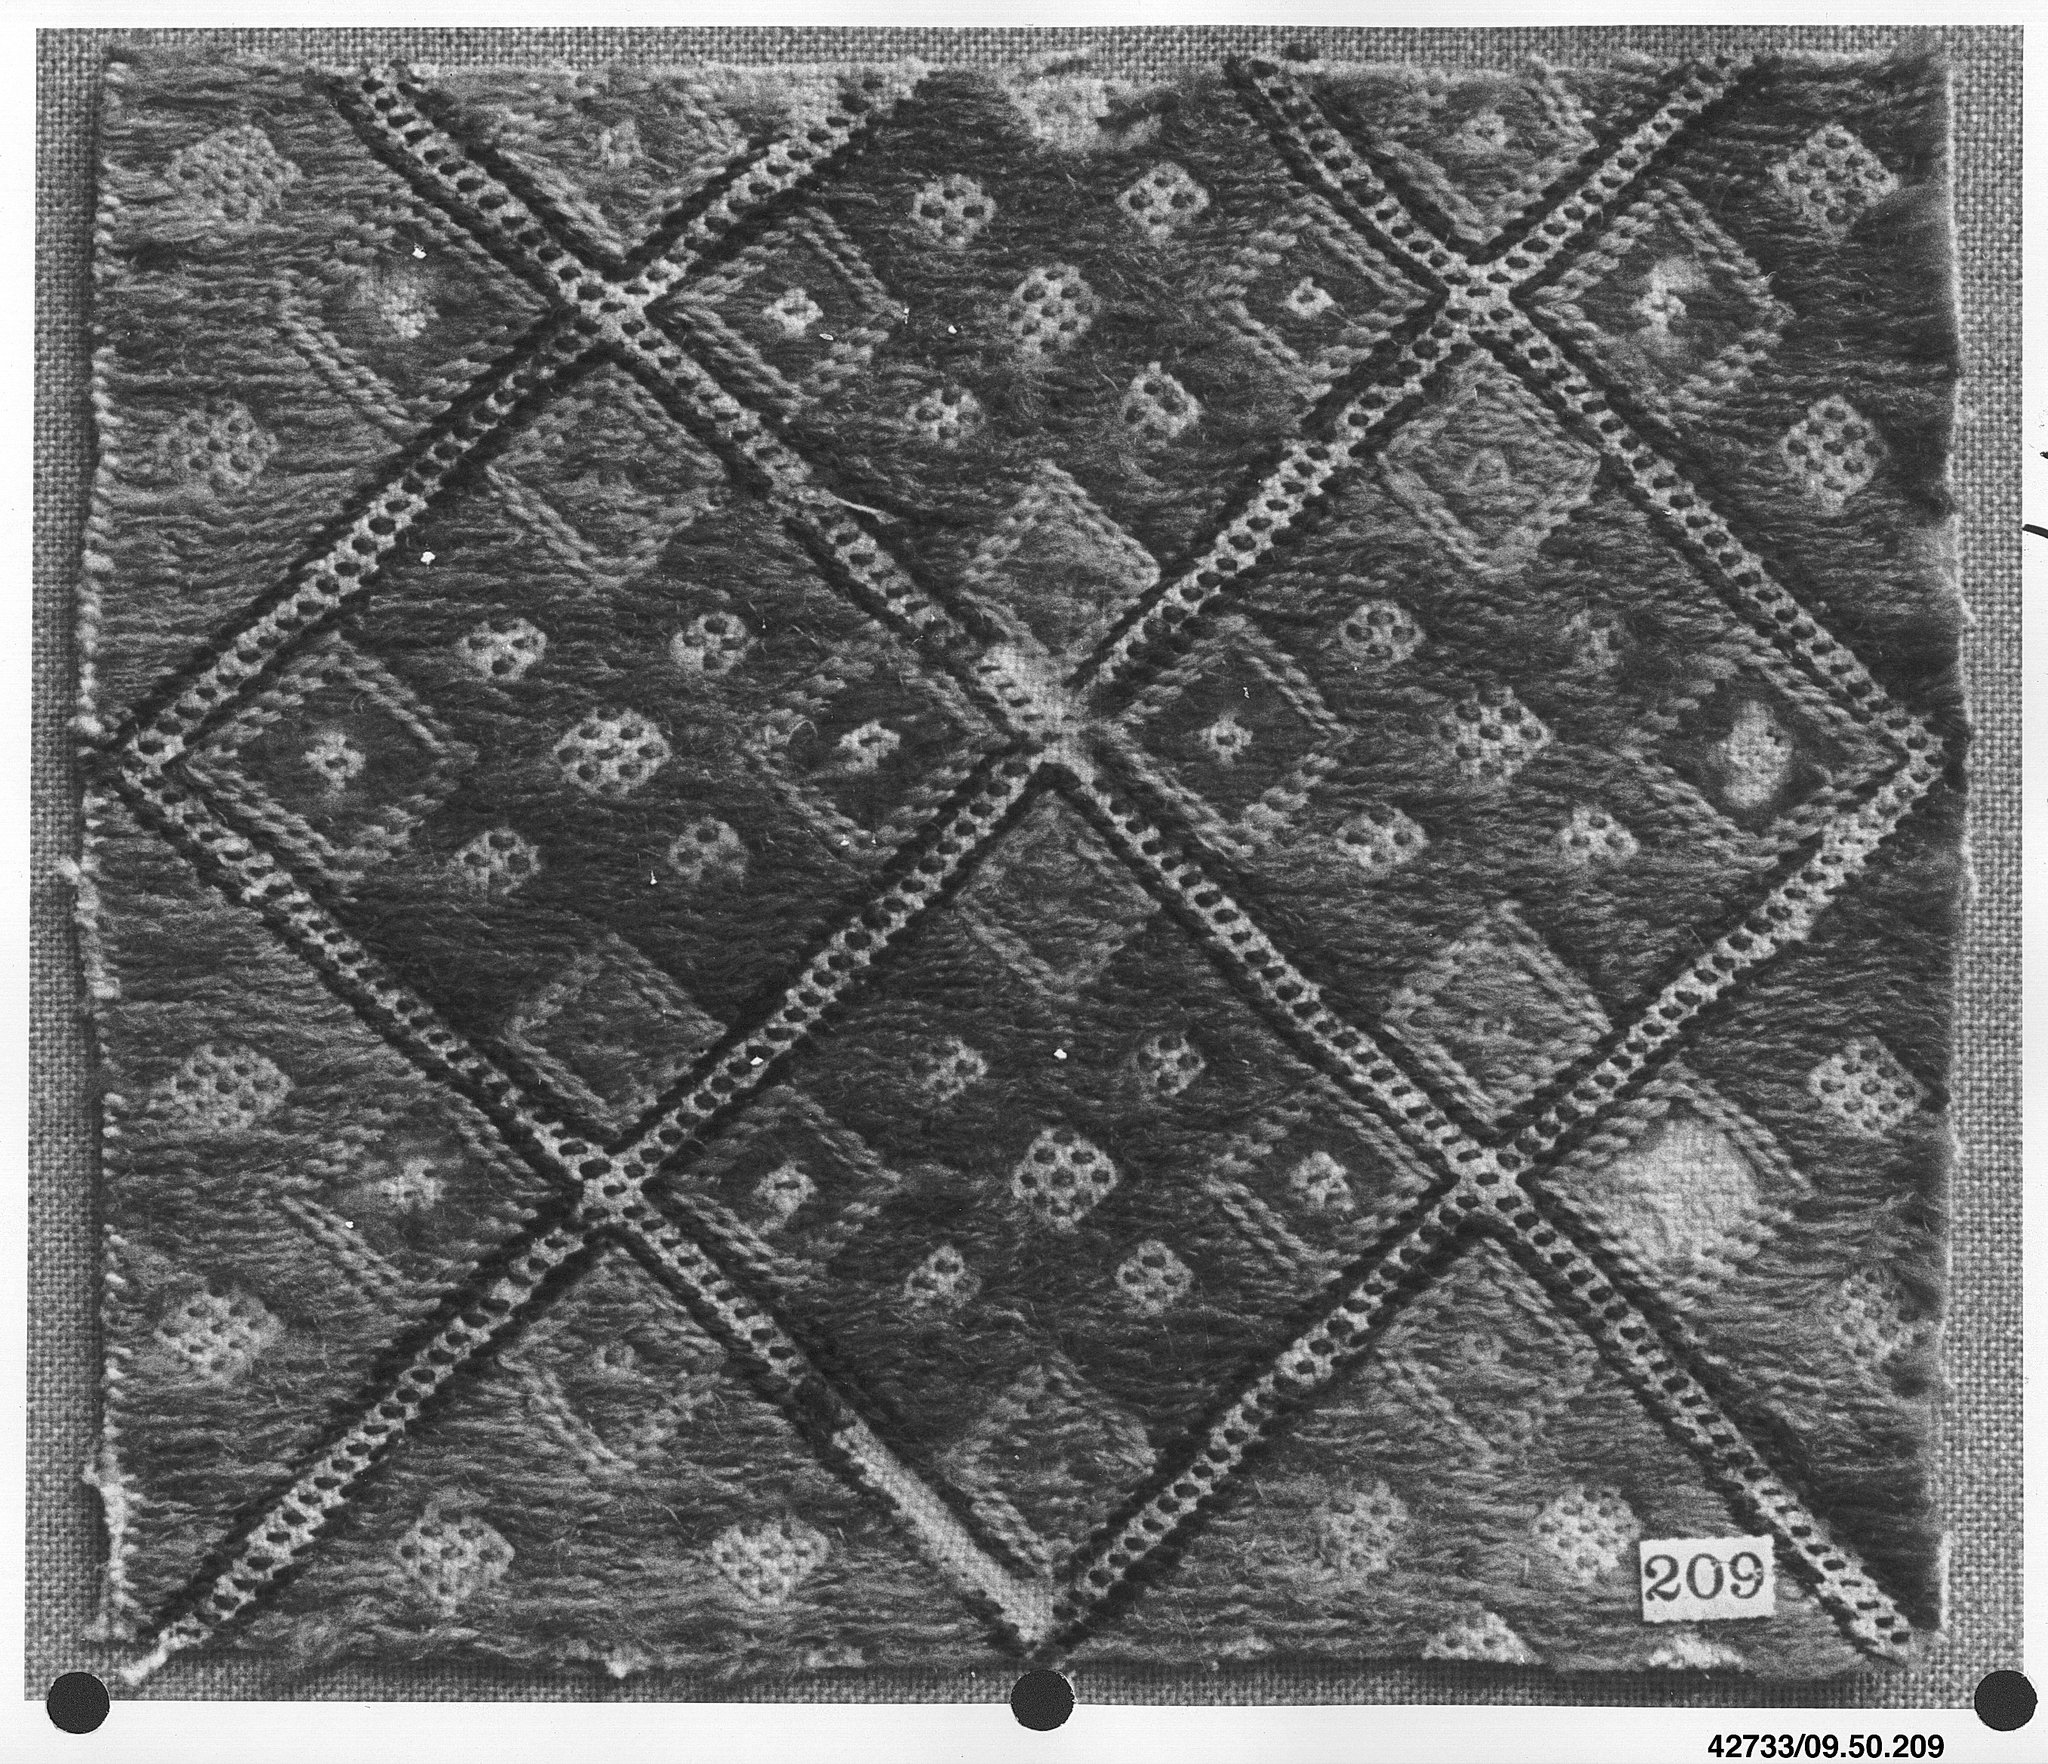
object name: costume fragment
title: Peasant costume fragment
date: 1701-1900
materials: canvas, wool